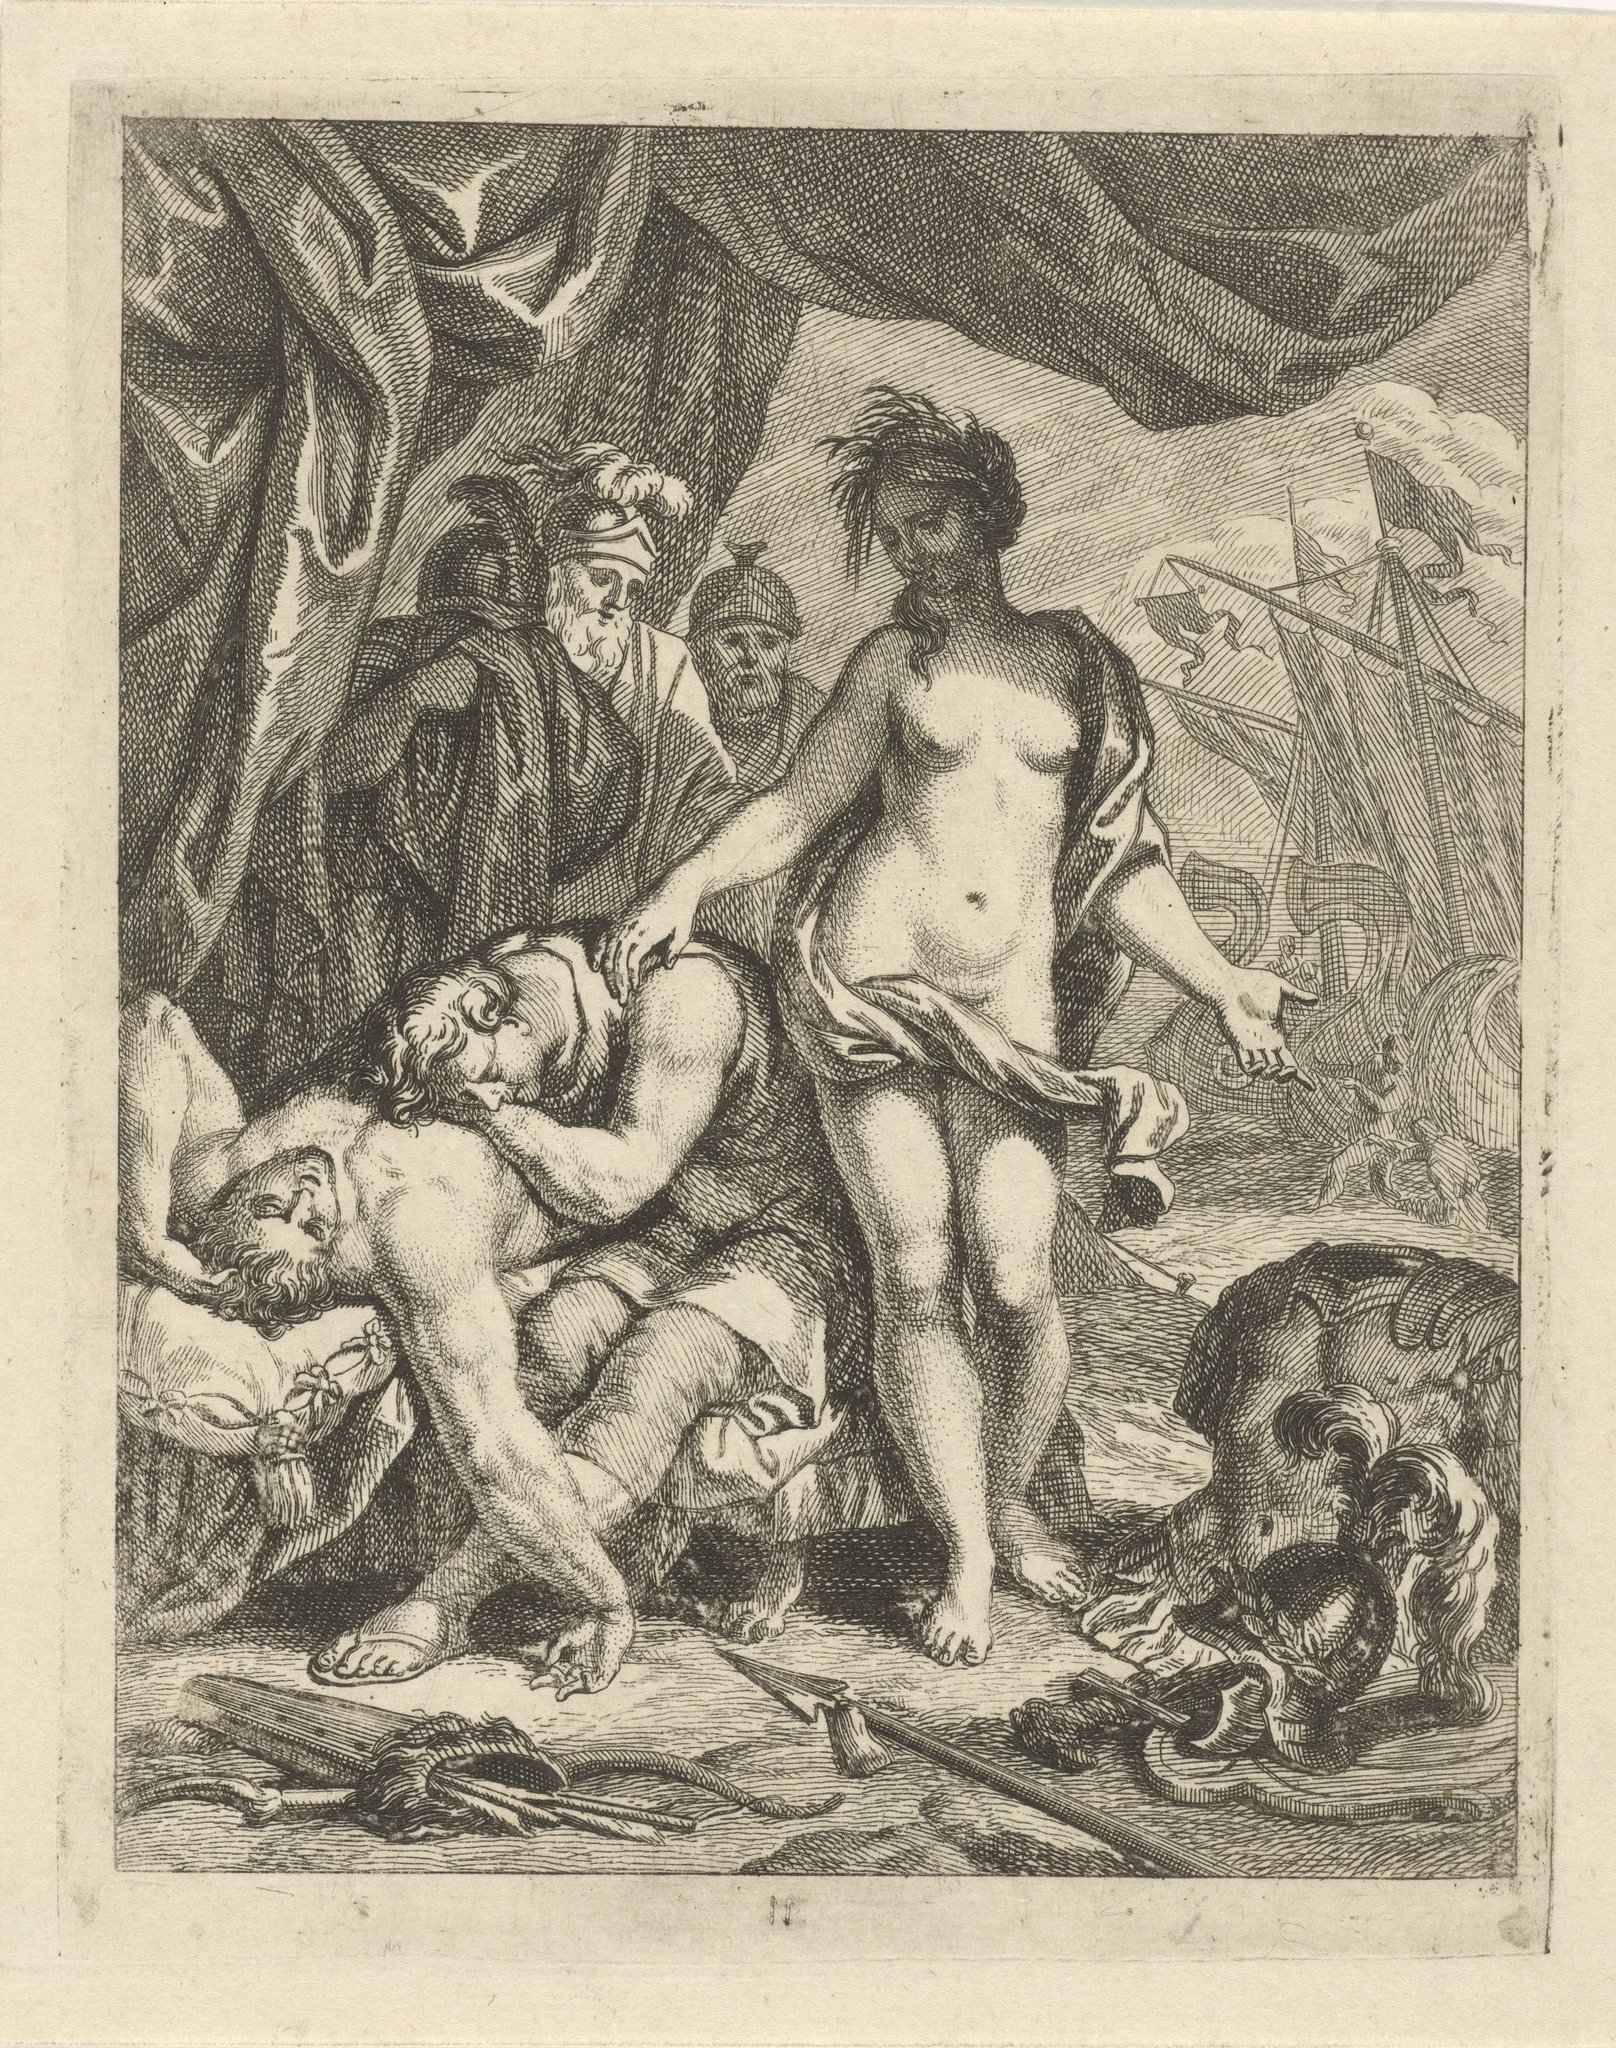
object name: print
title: Scènes uit het leven van Achilles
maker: j. alexander janssens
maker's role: print maker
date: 1700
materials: paper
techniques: engraving, etching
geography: southern netherlands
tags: homosexual love, achilles mourning over the body of patroclus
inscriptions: collector's mark: Lugt 2228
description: Achilles leunt, treurend, op het dode lichaam van zijn vriend Patroclus. Naast hen staat Thetis, troostend, met haar hand op de schouder van Achilles. Op de voorgrond Achilles' harnas en wapenrusting. Links op de achtergrond treurende soldaten. Midden onder: 11. Elfde prent uit een serie van veertien met scènes uit het leven van Achilles.